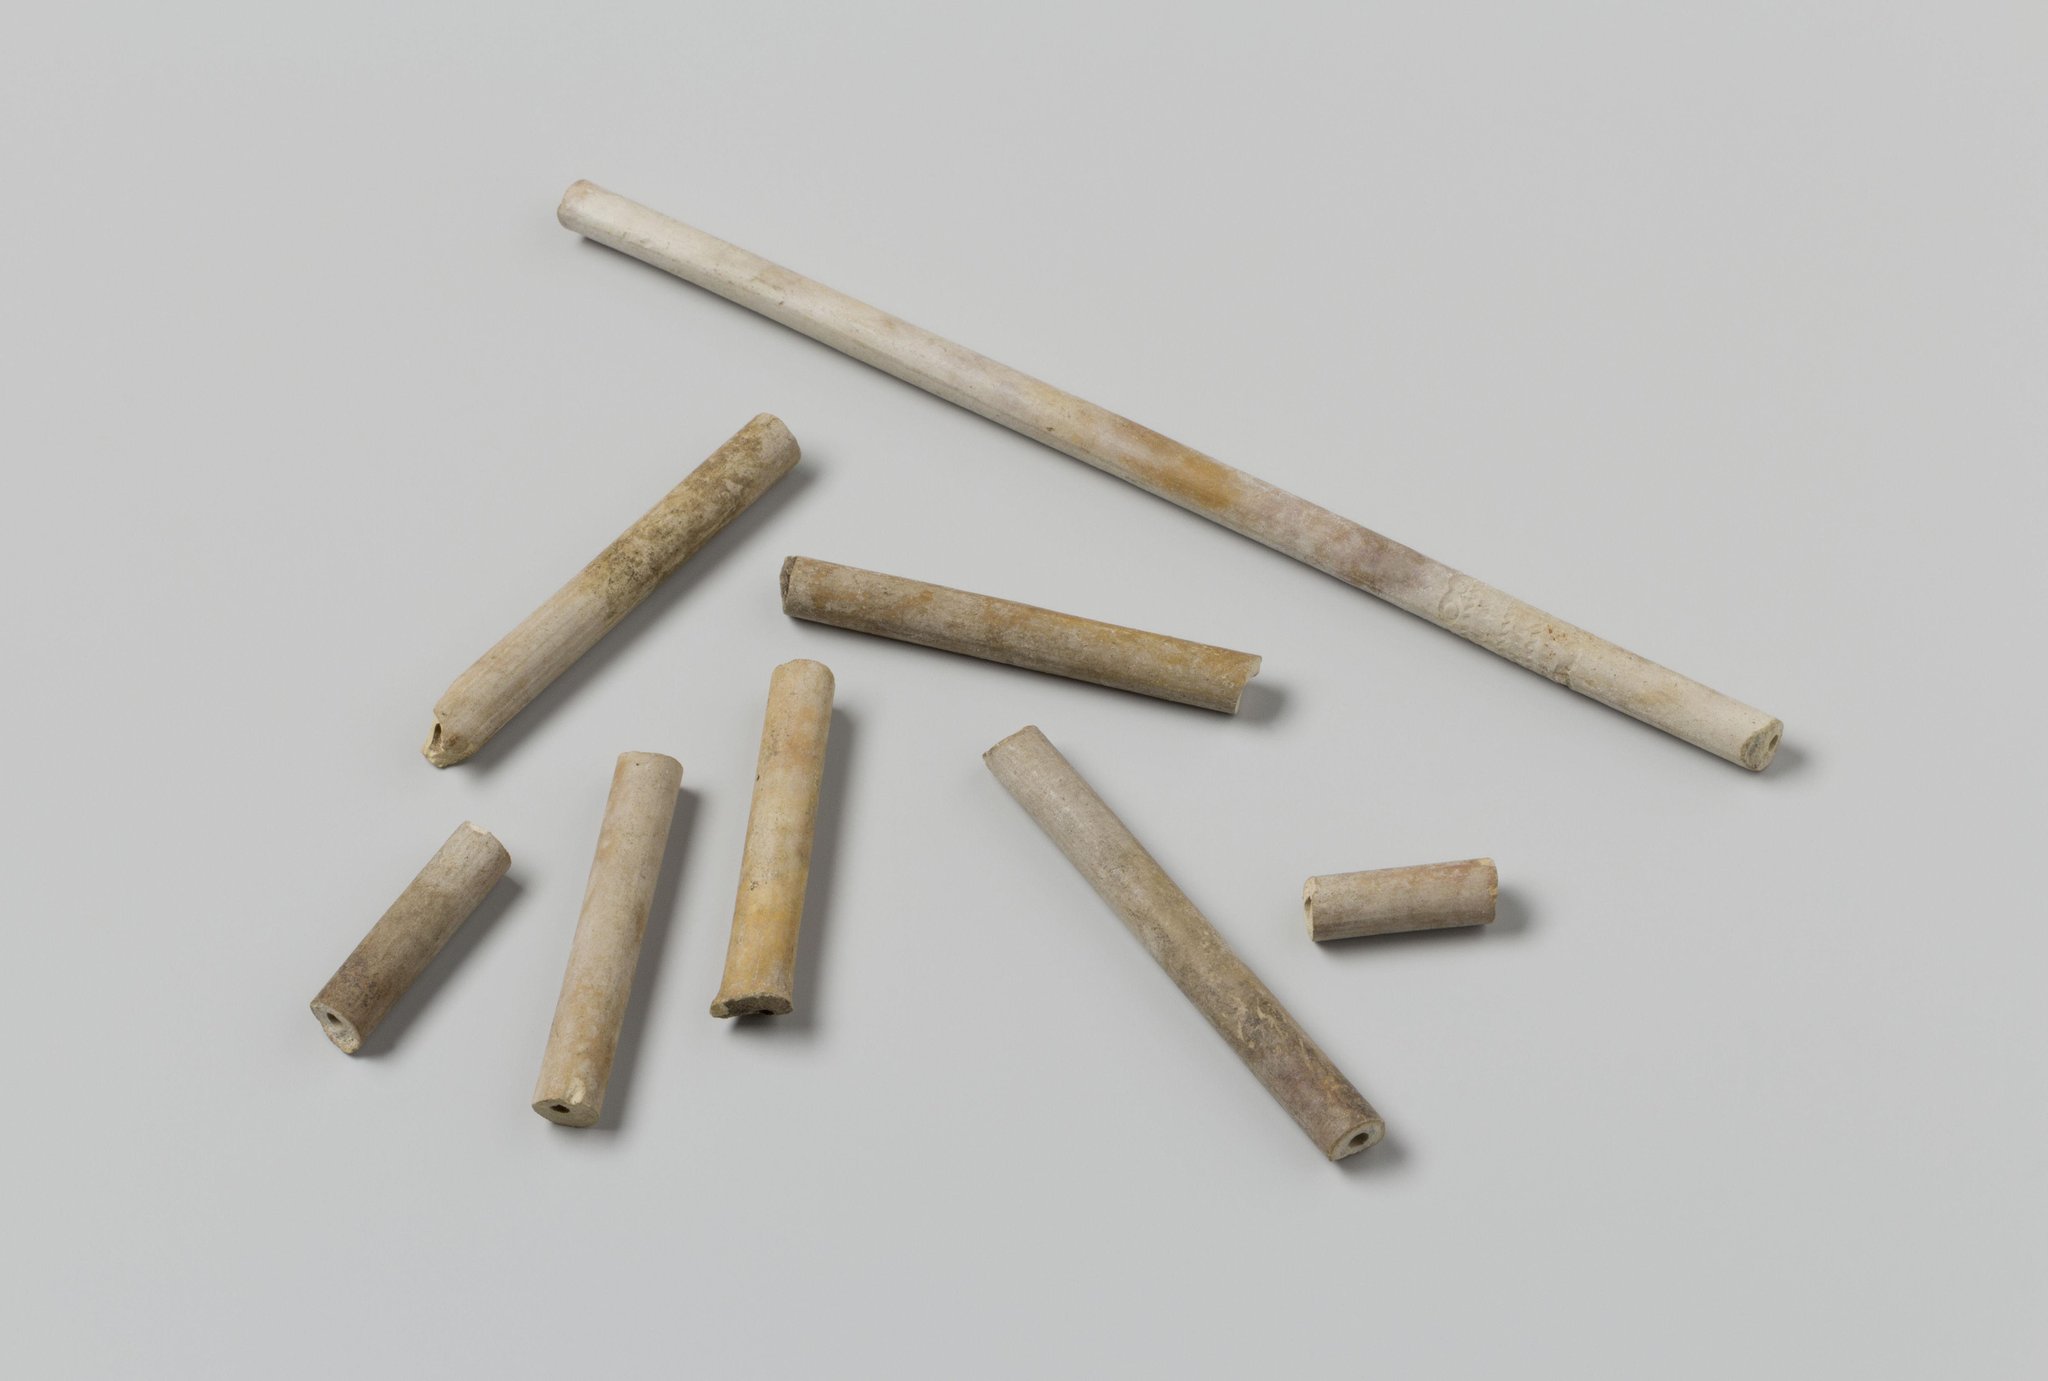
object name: pipe stem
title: Fragmenten pijpenstelen uit het wrak van de Oost-Indiëvaarder Hollandia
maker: Anonymous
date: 1700-1743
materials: clay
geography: netherlands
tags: verenigde oostindische compagnie, hollandia (schip), annet